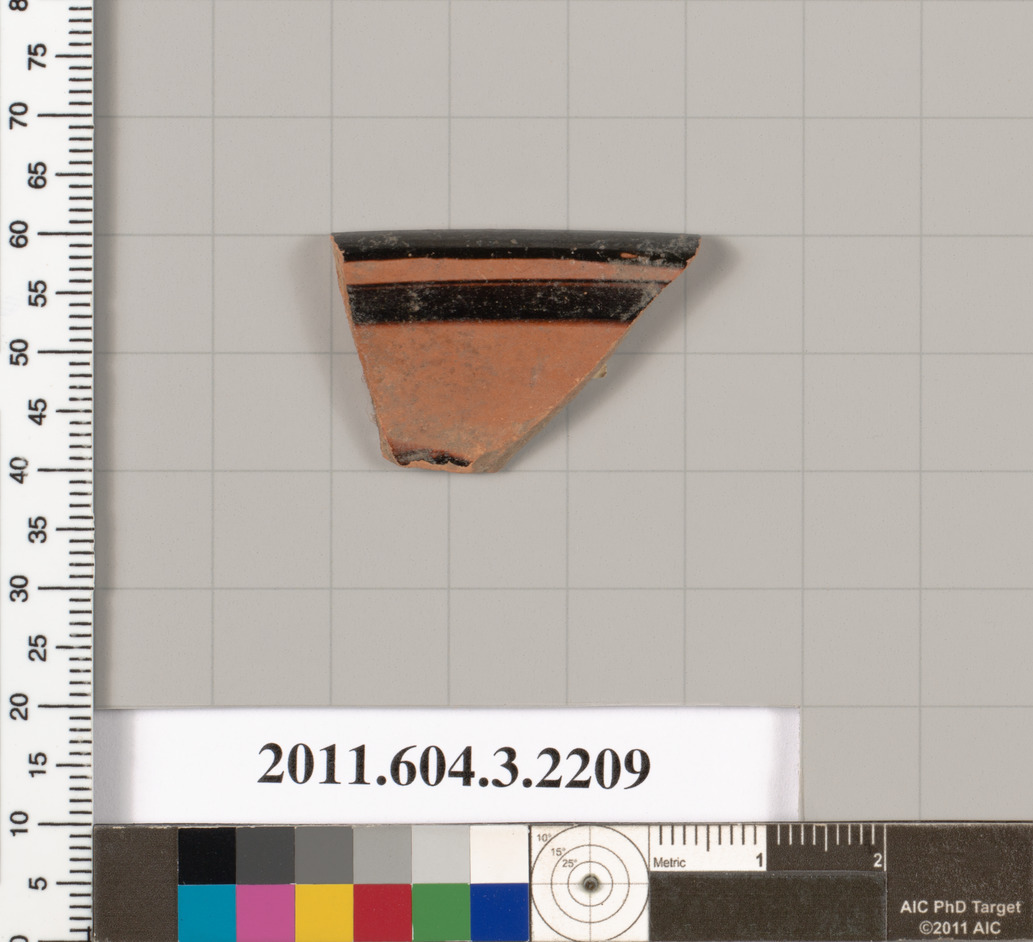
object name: kylix fragment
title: Terracotta fragment of a kylix (drinking cup)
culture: greek, attic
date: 600-401 BCE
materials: terracotta